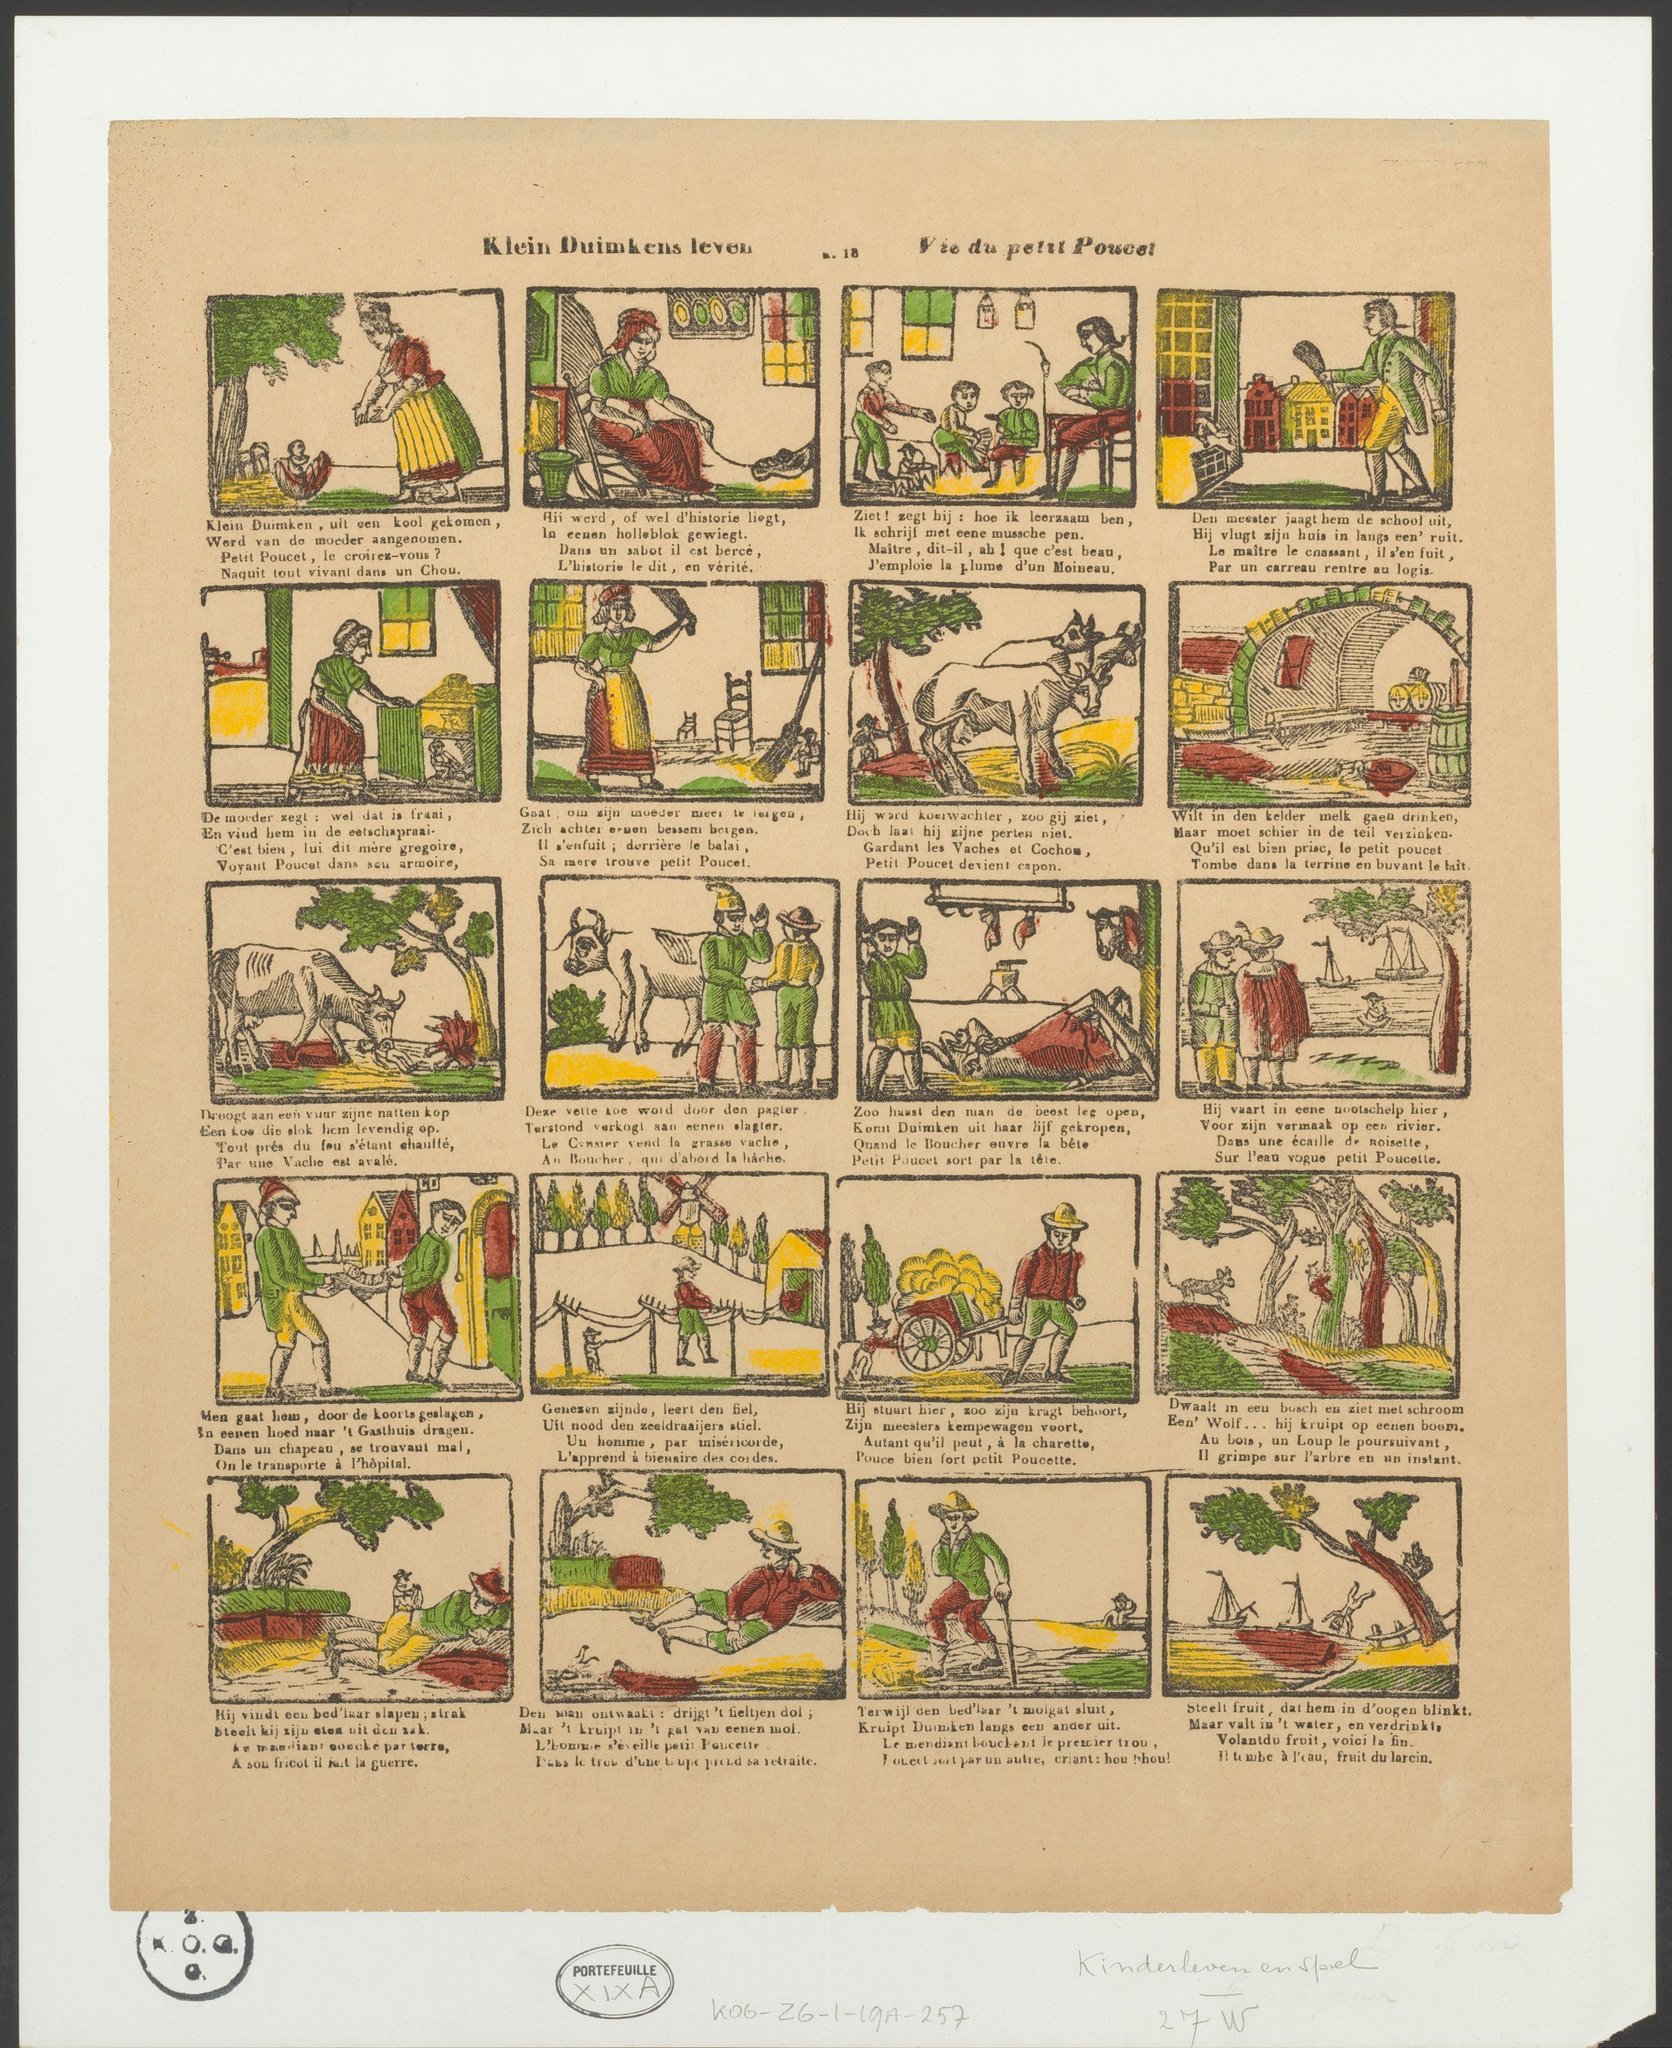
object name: popular print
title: Klein Duimkens leven / Vie du petit Poucel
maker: Anonymous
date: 1856-1900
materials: paper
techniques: hand coloring, letterpress printing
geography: turnhout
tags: tales and fairy tales: little thumbling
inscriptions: stamp, collector's mark: Lugt 1641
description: Blad met twintig voorstellingen uit het sprookje van Klein Duimpje. Onder elke afbeelding een tweeregelig vers in het Nederlands en in het Frans. Genummerd midden boven: n. 18. Onderwerpsrubrieken binnen de Atlas Zeden en Gewoonten: Zeden en Gewoonten in Engeren Zin, Des menschen beging, midden en einde, Kinderleven – Kinderspel en Kinderprenten.